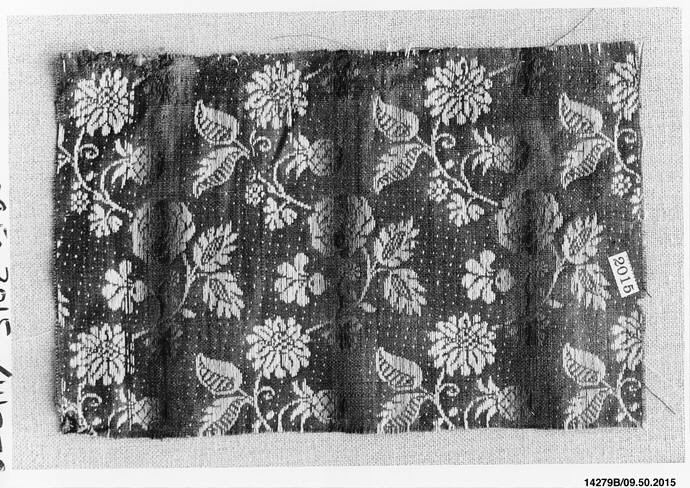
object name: fragment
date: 1801-1900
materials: wool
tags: flowers,leaves